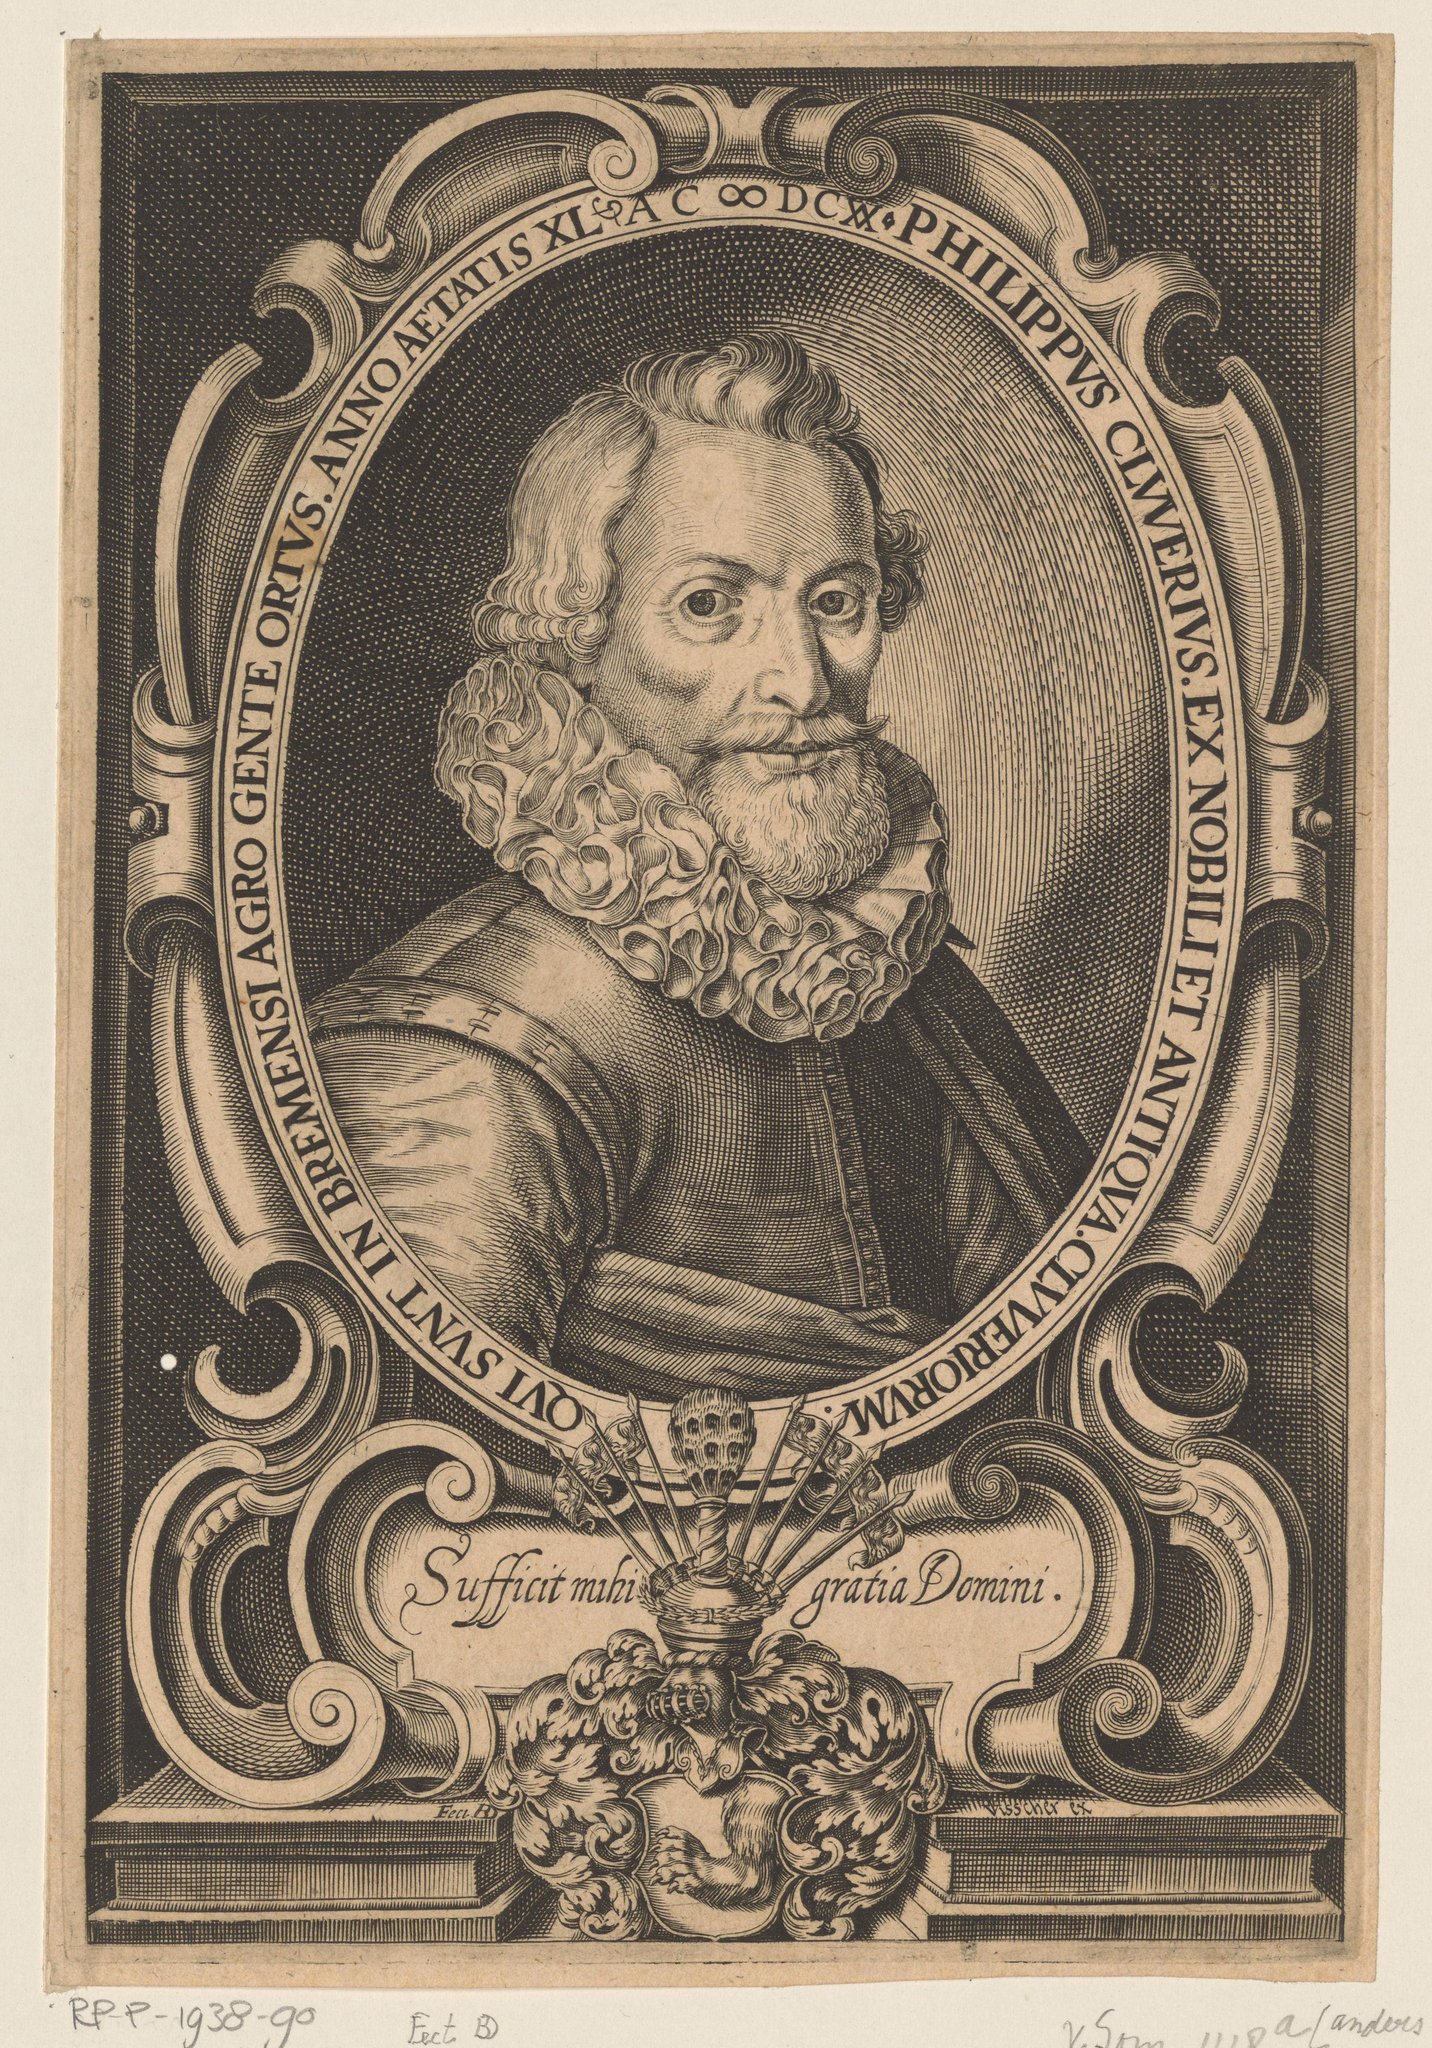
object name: print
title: Portret van Philipp Cluver op 40-jarige leeftijd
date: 1620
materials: paper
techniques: engraving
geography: amsterdam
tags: leiden, historical persons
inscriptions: collector's mark: Lugt 2228